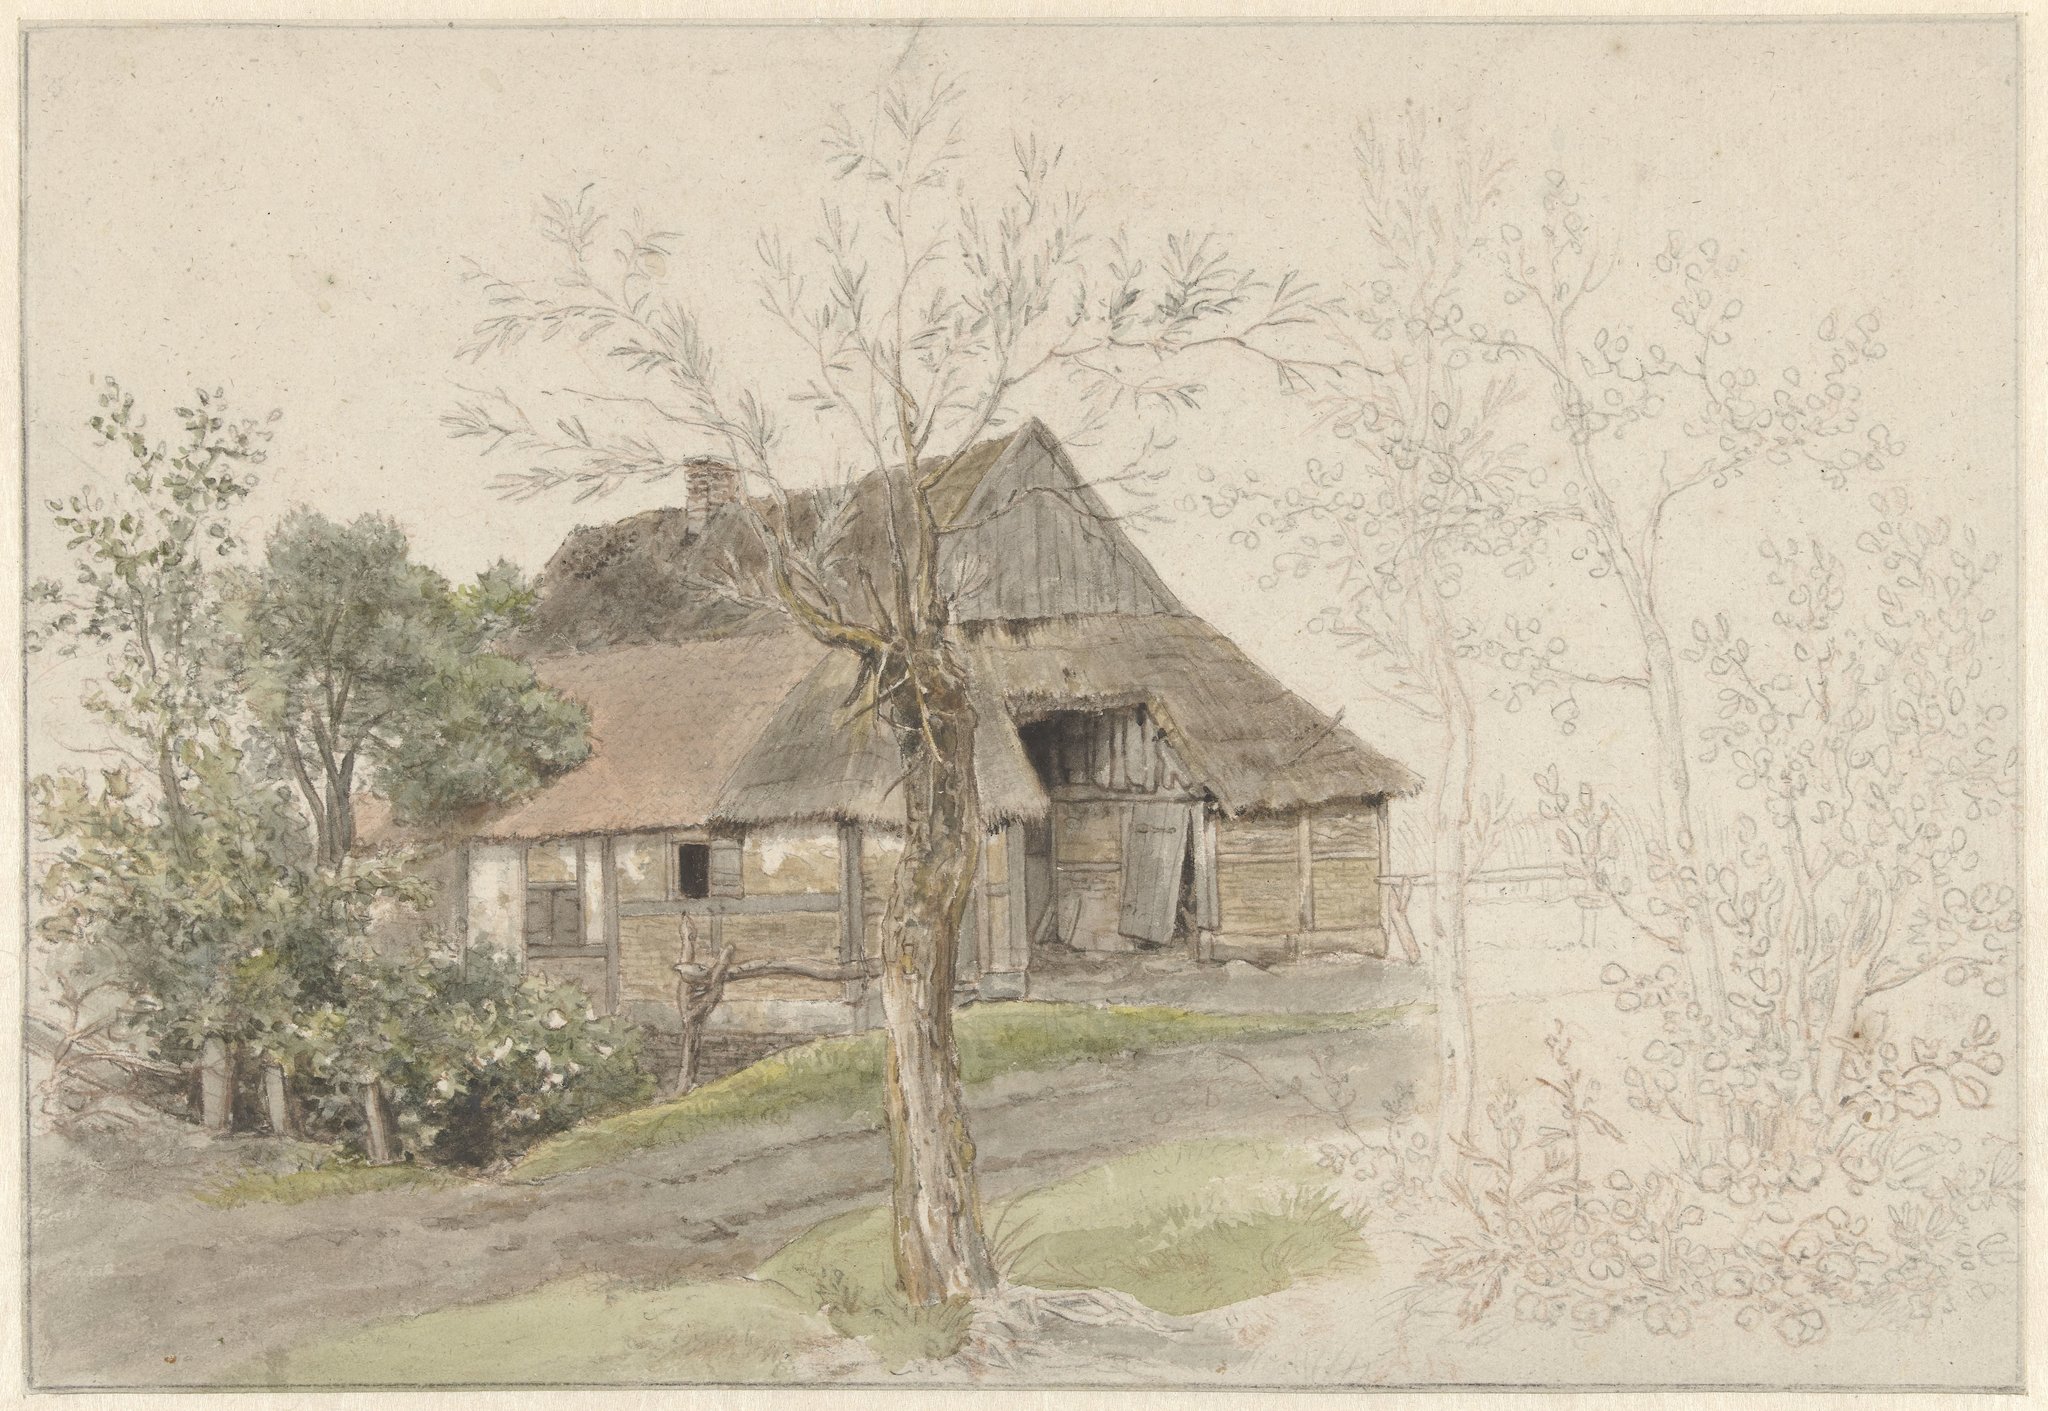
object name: watercolor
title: Boerenhuis met bomen te Delden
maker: jacob ernst marcus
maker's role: draughtsman, print maker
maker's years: 1774-1826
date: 1810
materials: chalk, paper, watercolor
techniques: brush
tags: farm (building)